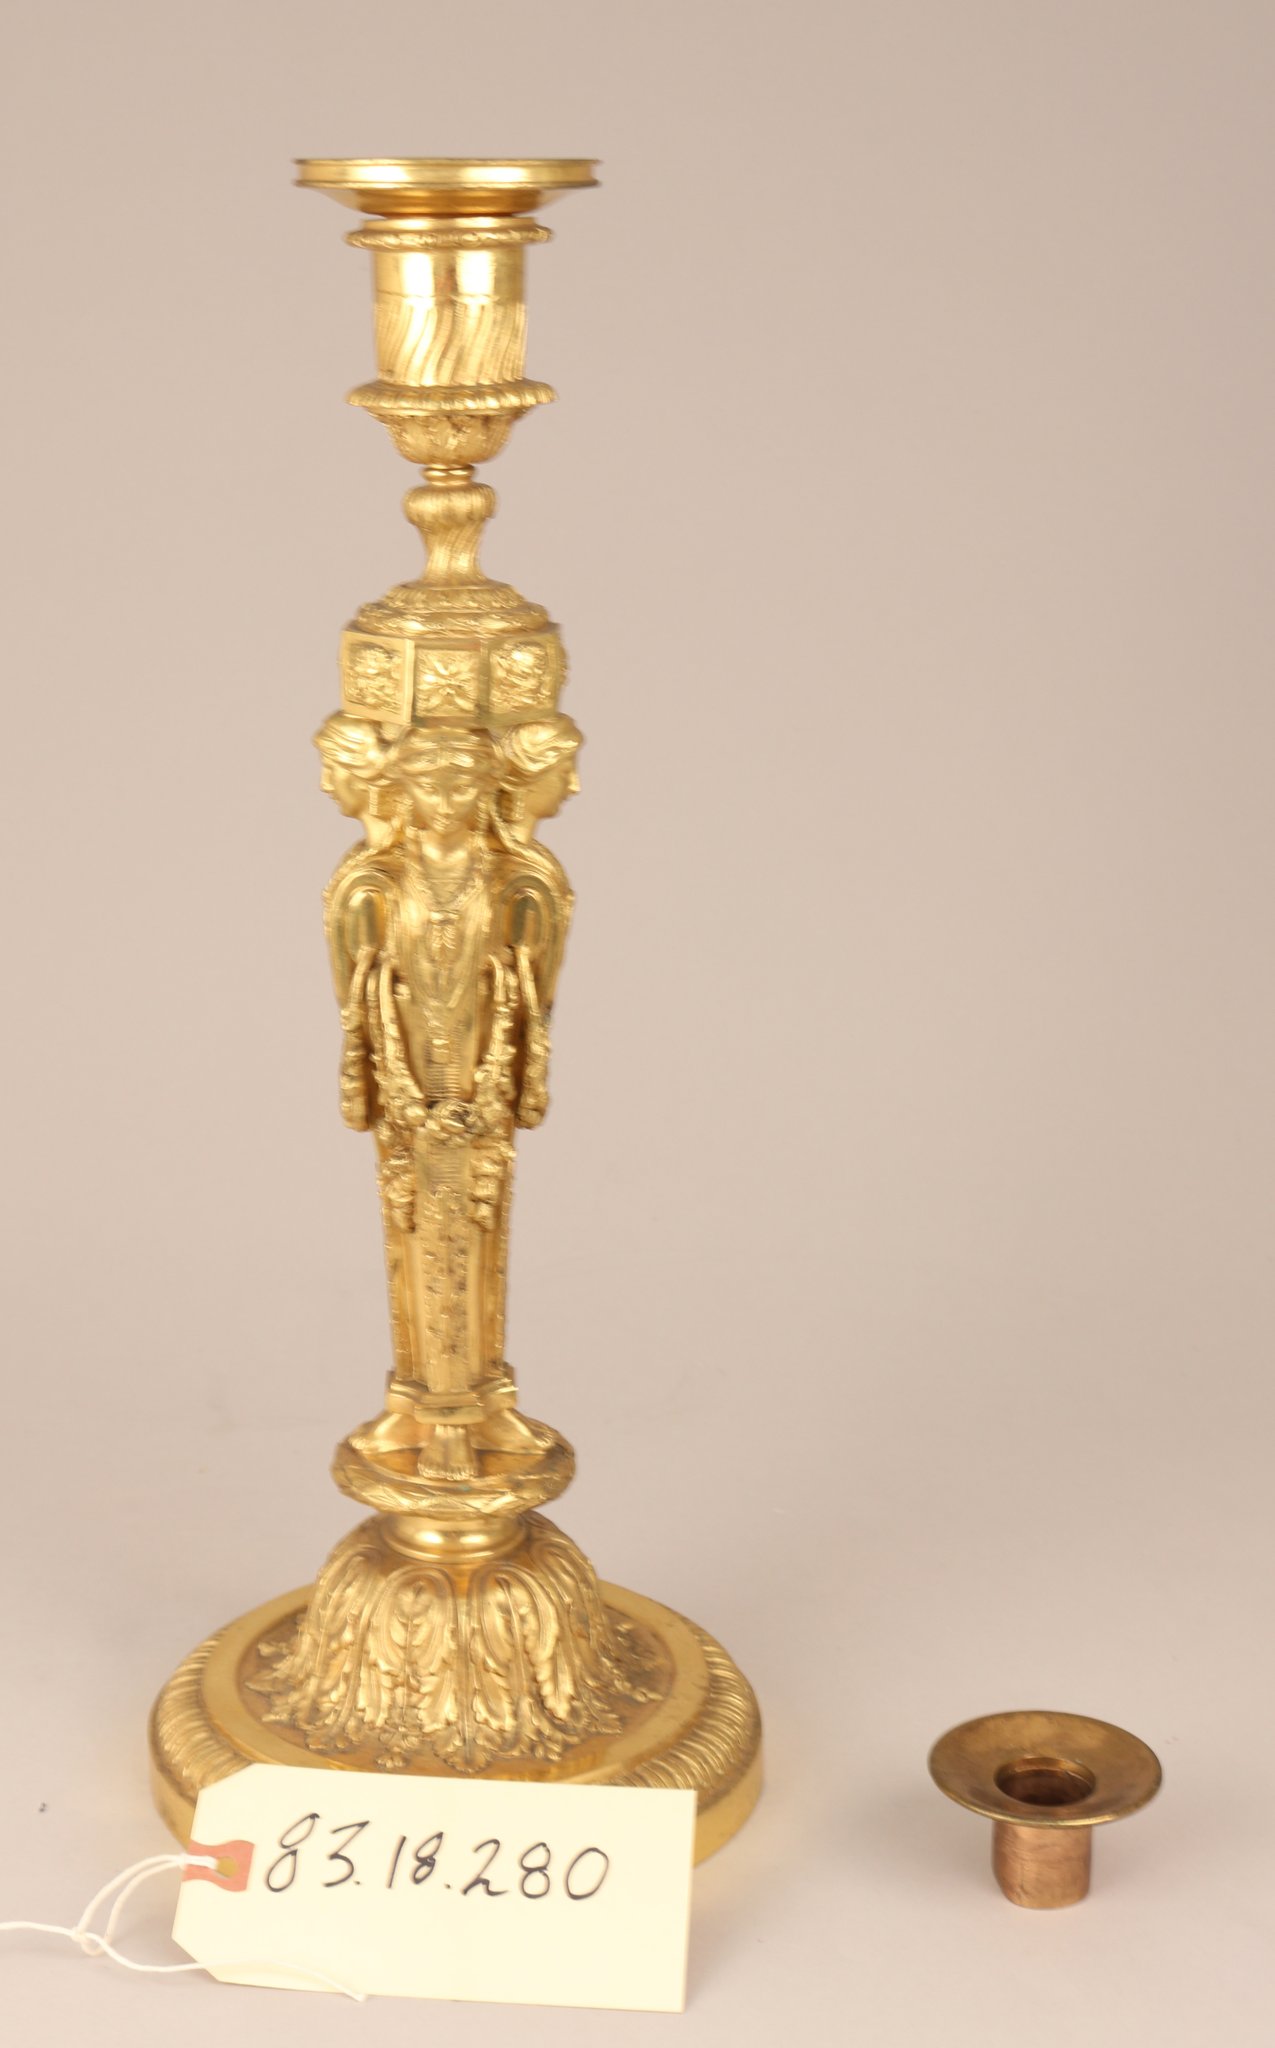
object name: candlestick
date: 1801-1900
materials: gilt bronze